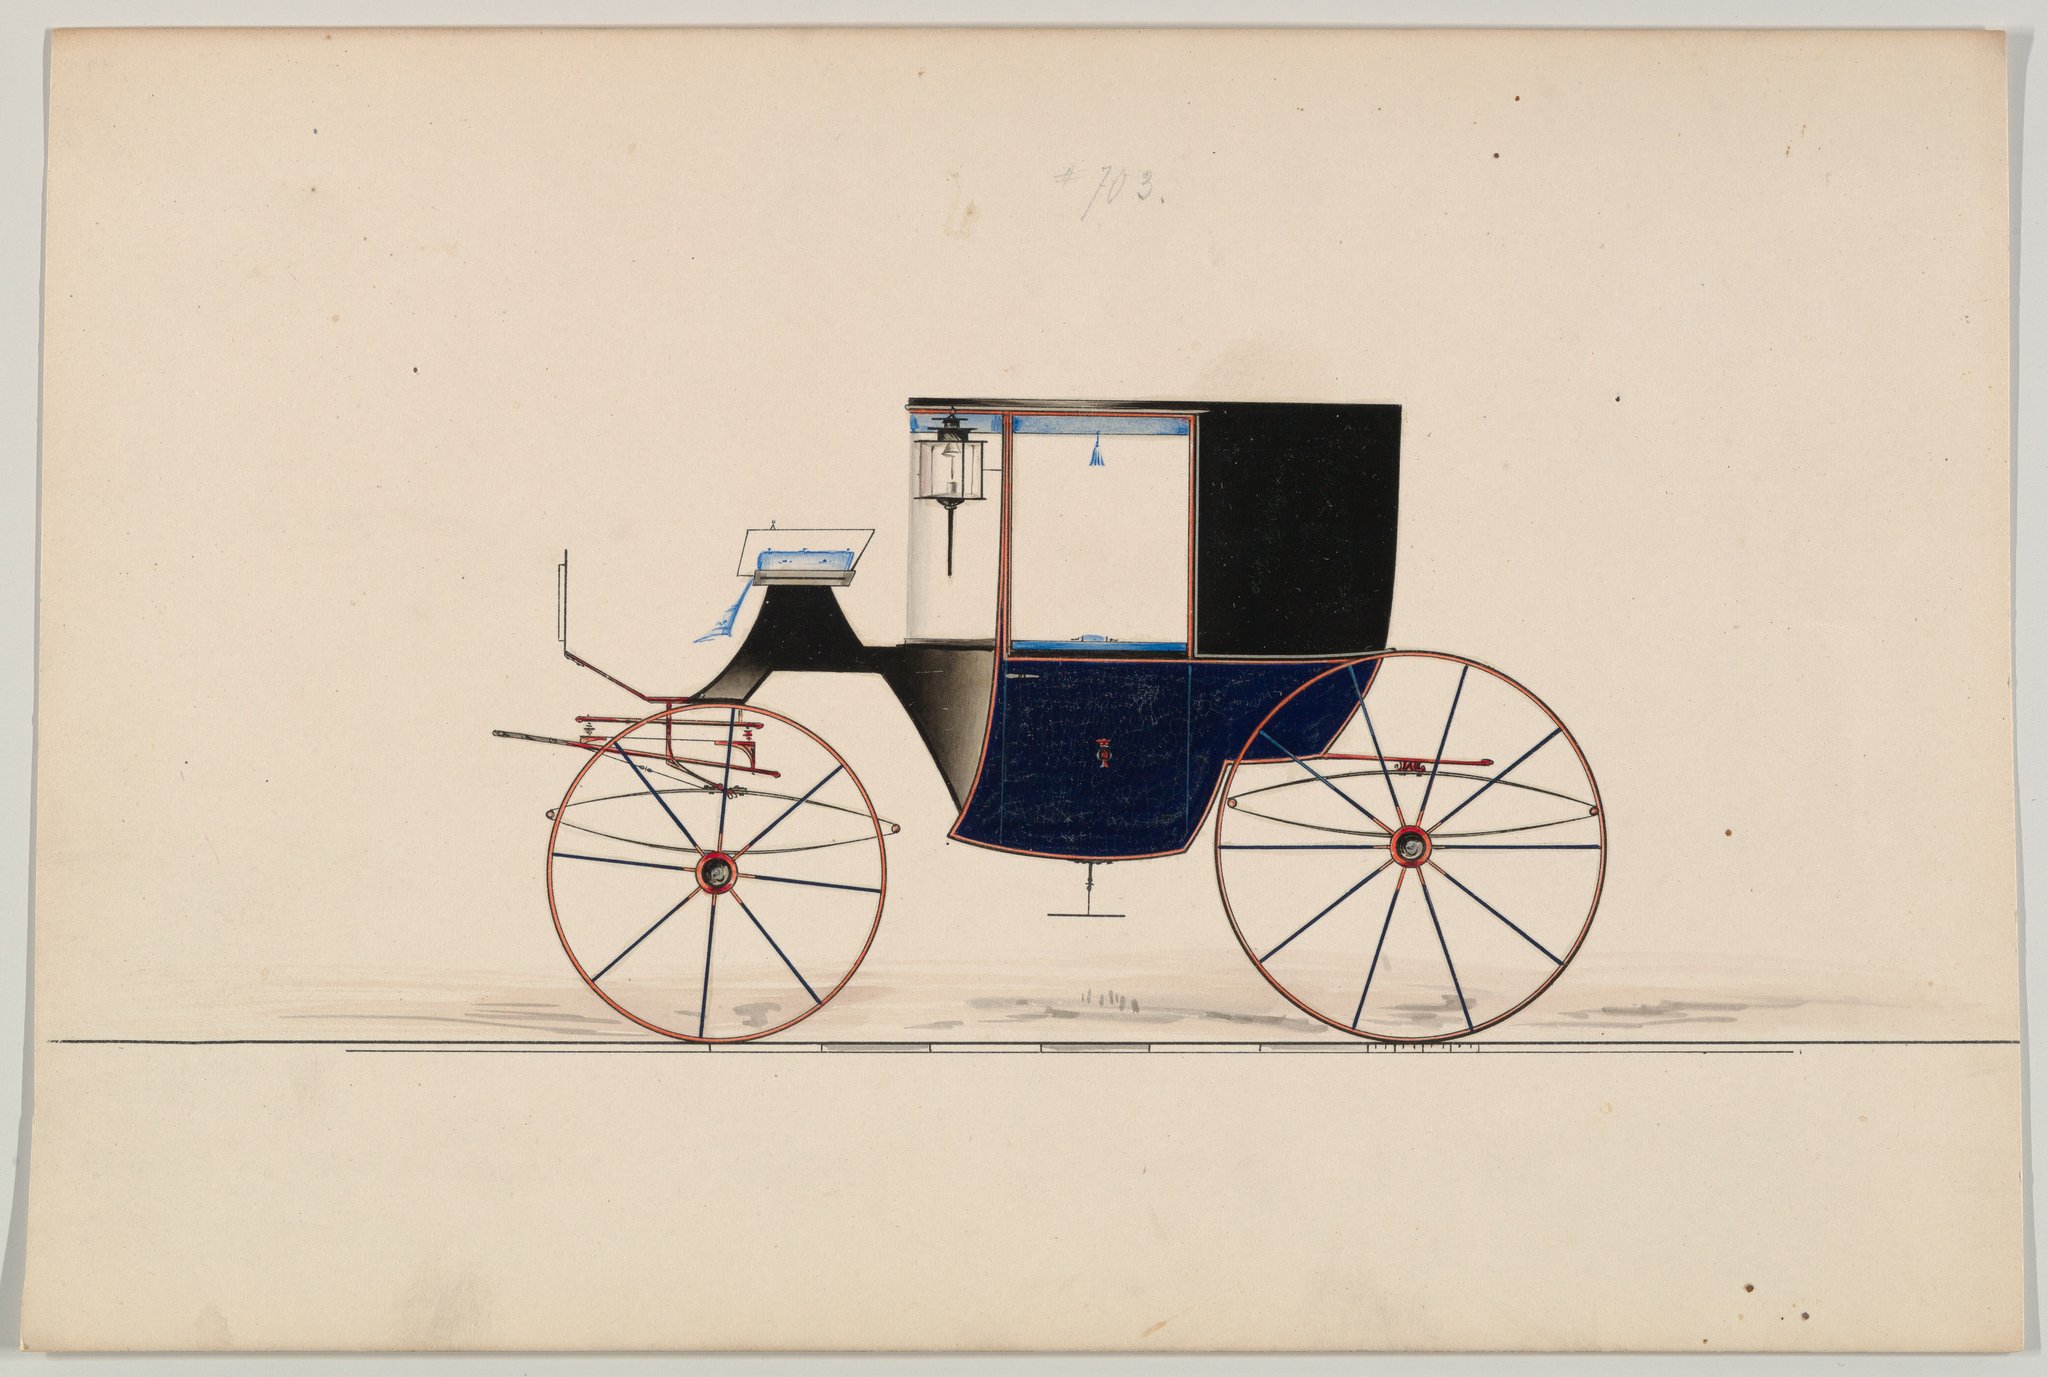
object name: drawing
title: Coupé #703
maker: brewster & co.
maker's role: manufacturer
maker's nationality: american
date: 1850-1870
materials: gouache, gum arabic, watercolor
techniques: pen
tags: carriages